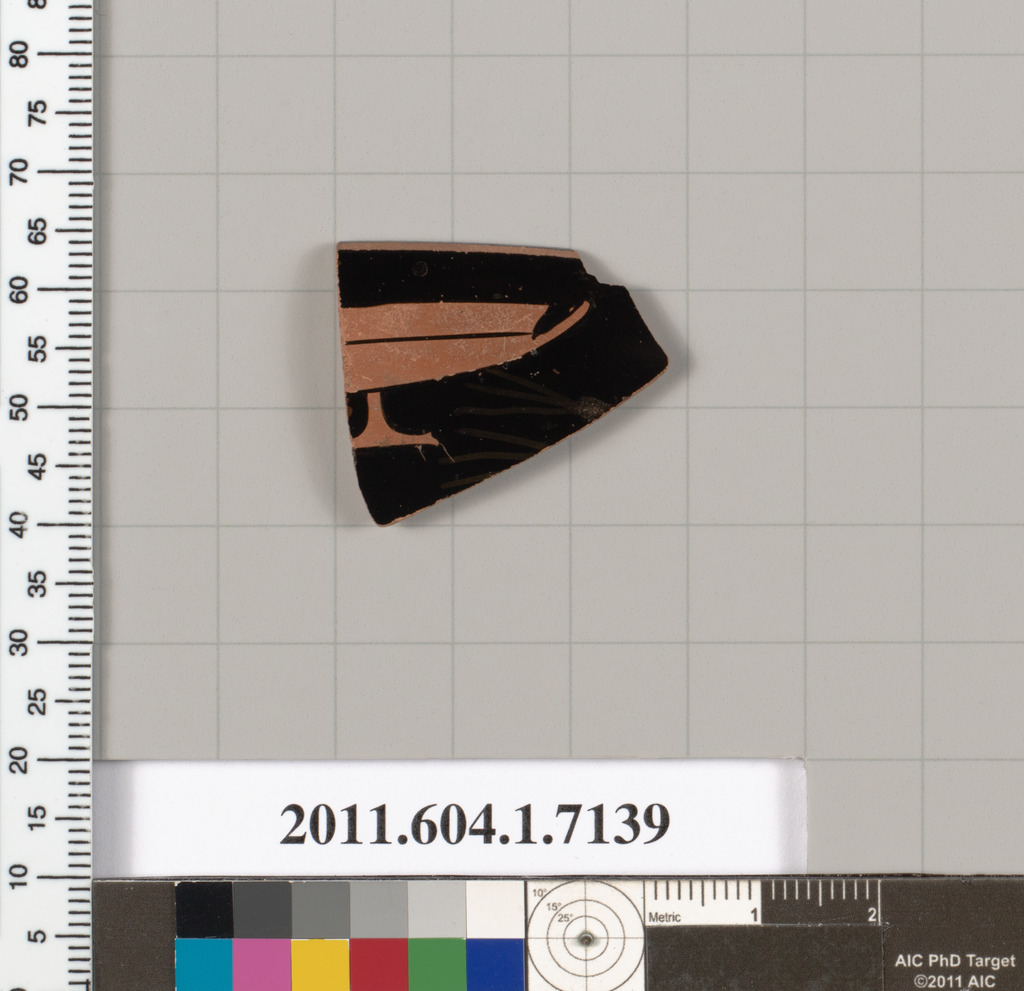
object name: kylix fragment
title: Terracotta rim fragment of a kylix (drinking cup)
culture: greek, attic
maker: makron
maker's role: artist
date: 500-480 BCE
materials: terracotta